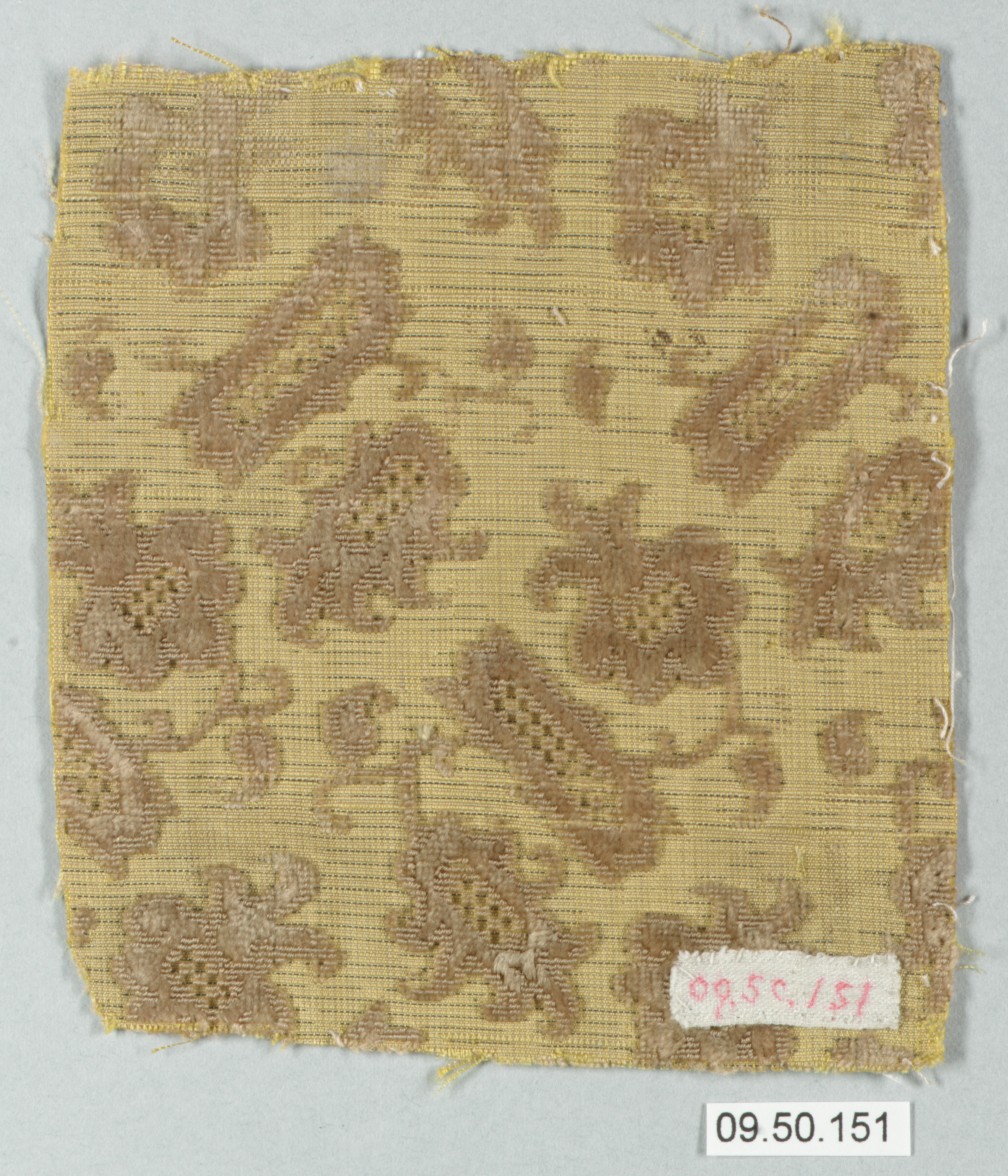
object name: piece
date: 1501-1700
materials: metal thread, silk